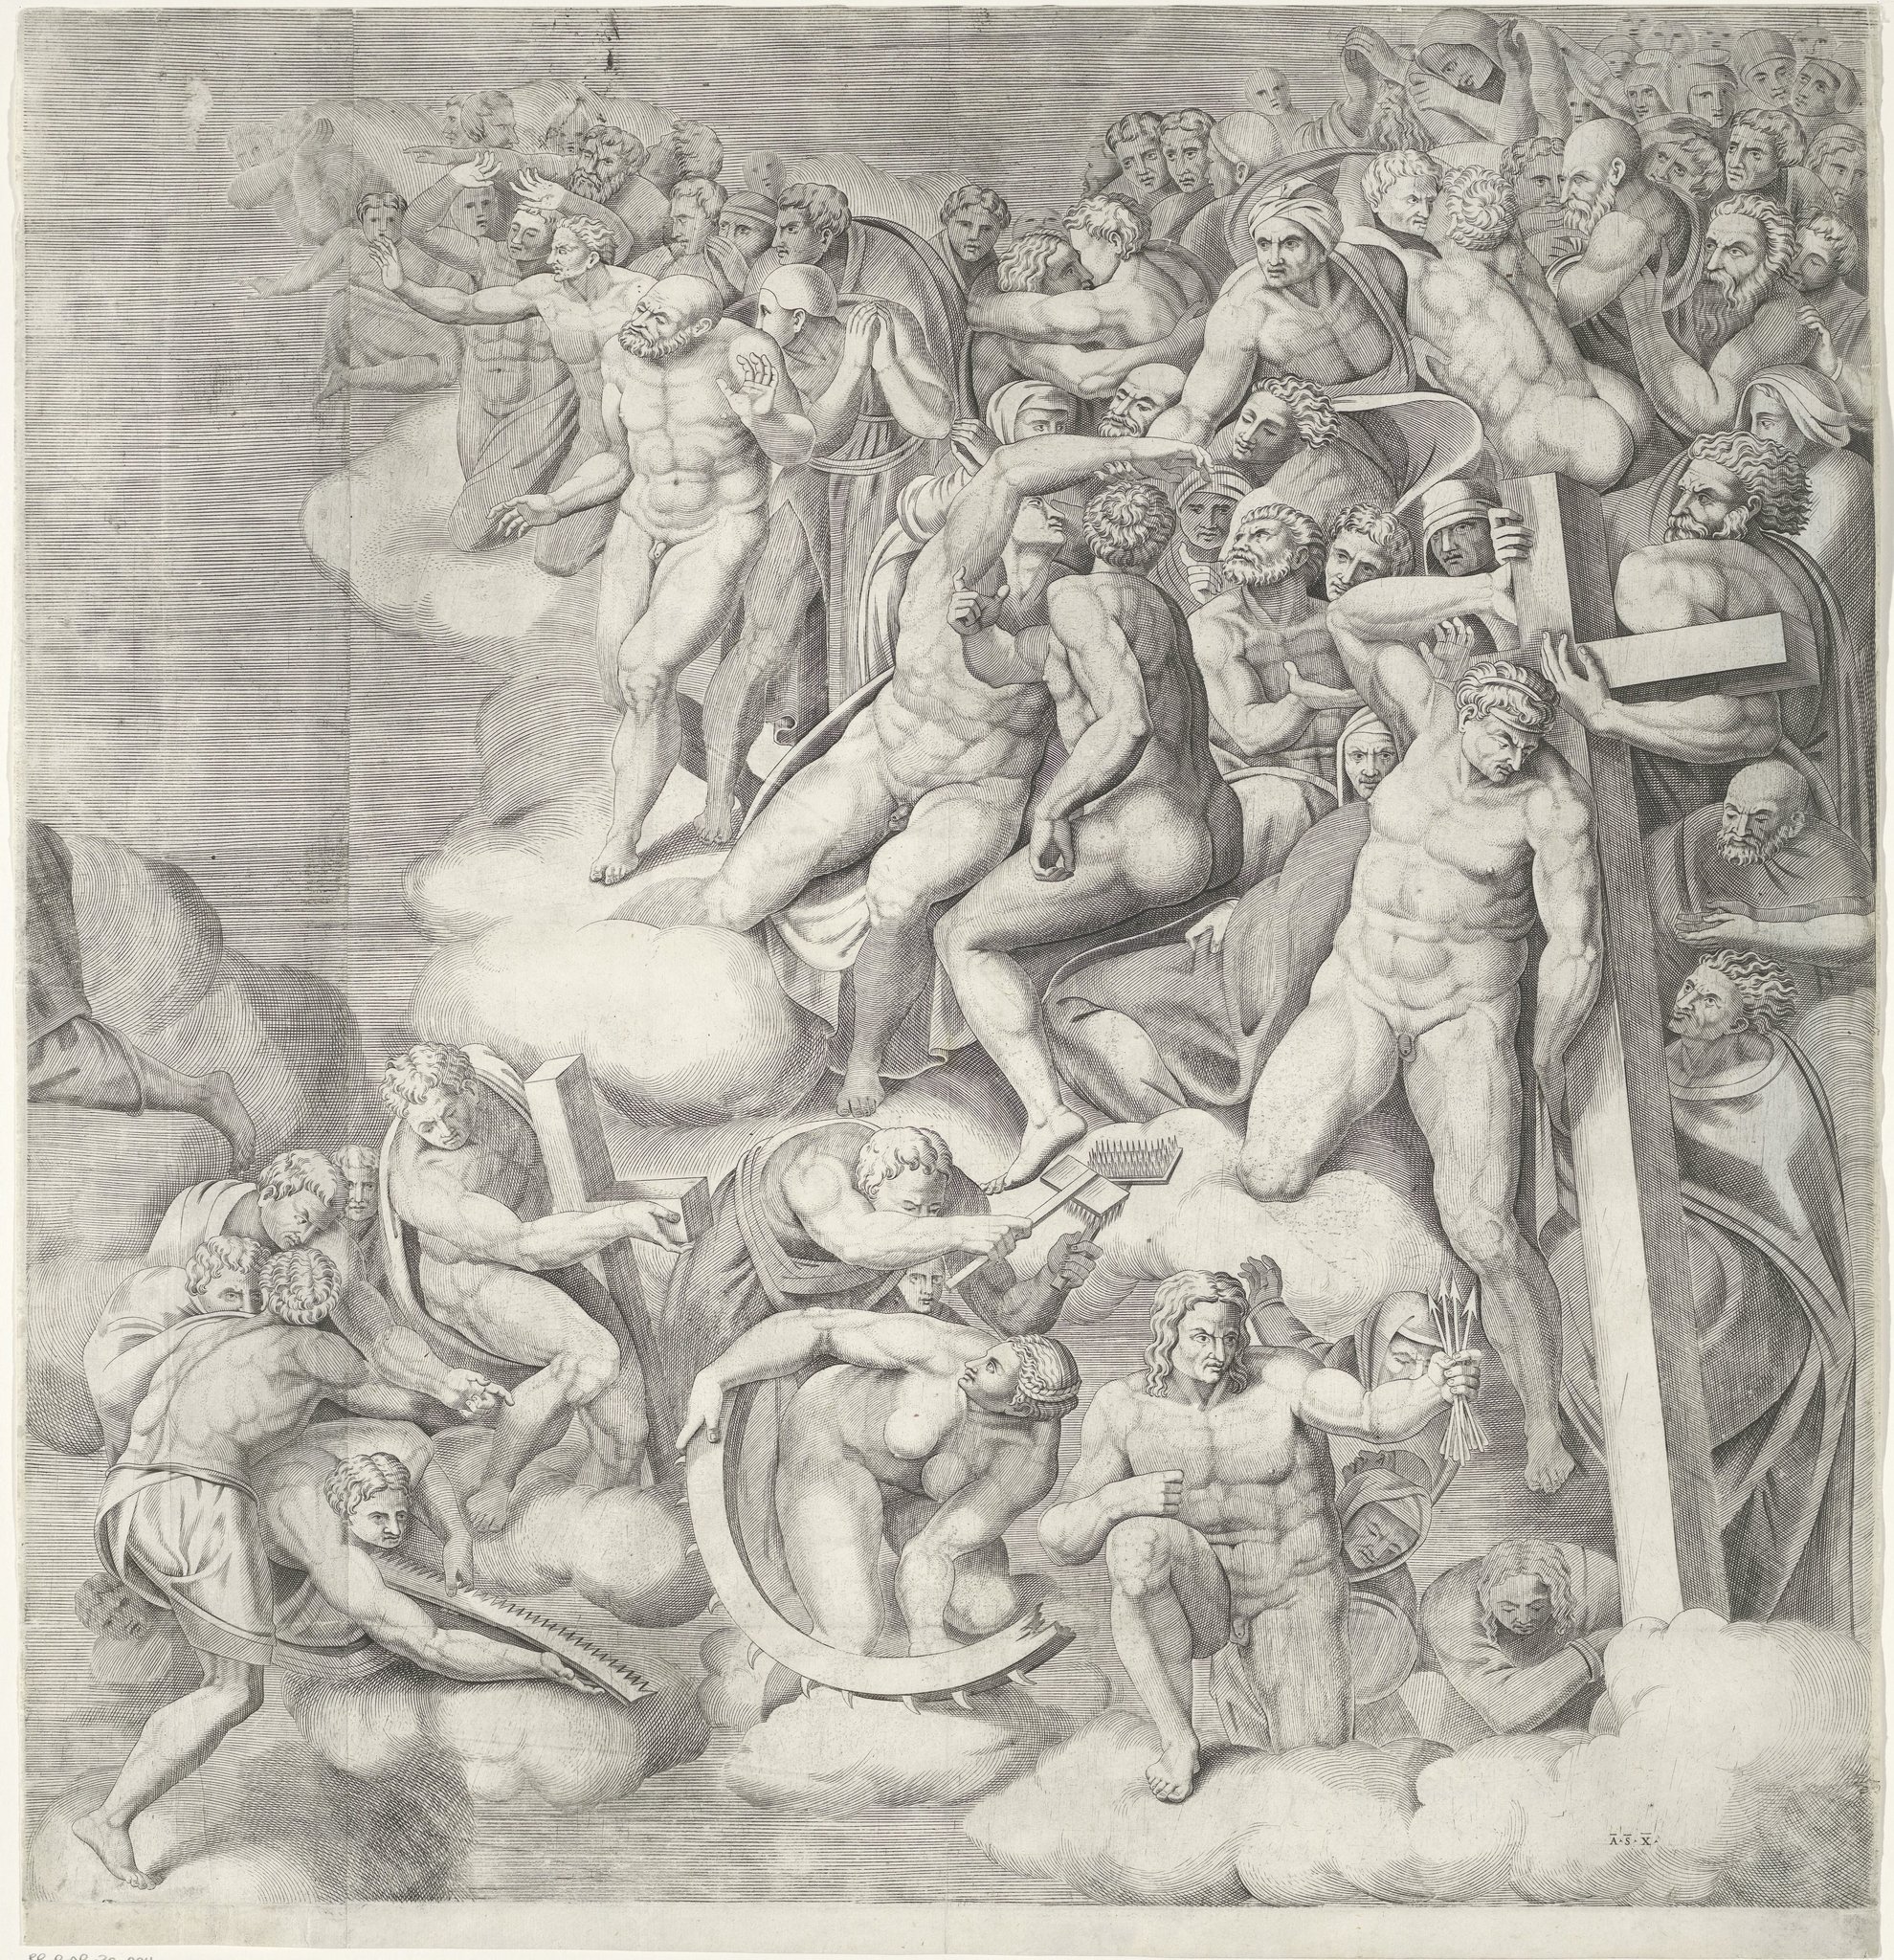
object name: print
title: Het laatste oordeel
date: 1548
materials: paper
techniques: engraving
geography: rome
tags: last judgement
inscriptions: collector's mark: Lugt 240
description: Prent maakt deel uit van een groep van twaalf prenten die samen één grote voorstelling vormen naar het fresco met het Laatste Oordeel door Michelangelo in de Sixtijnse Kapel in het Vaticaan.